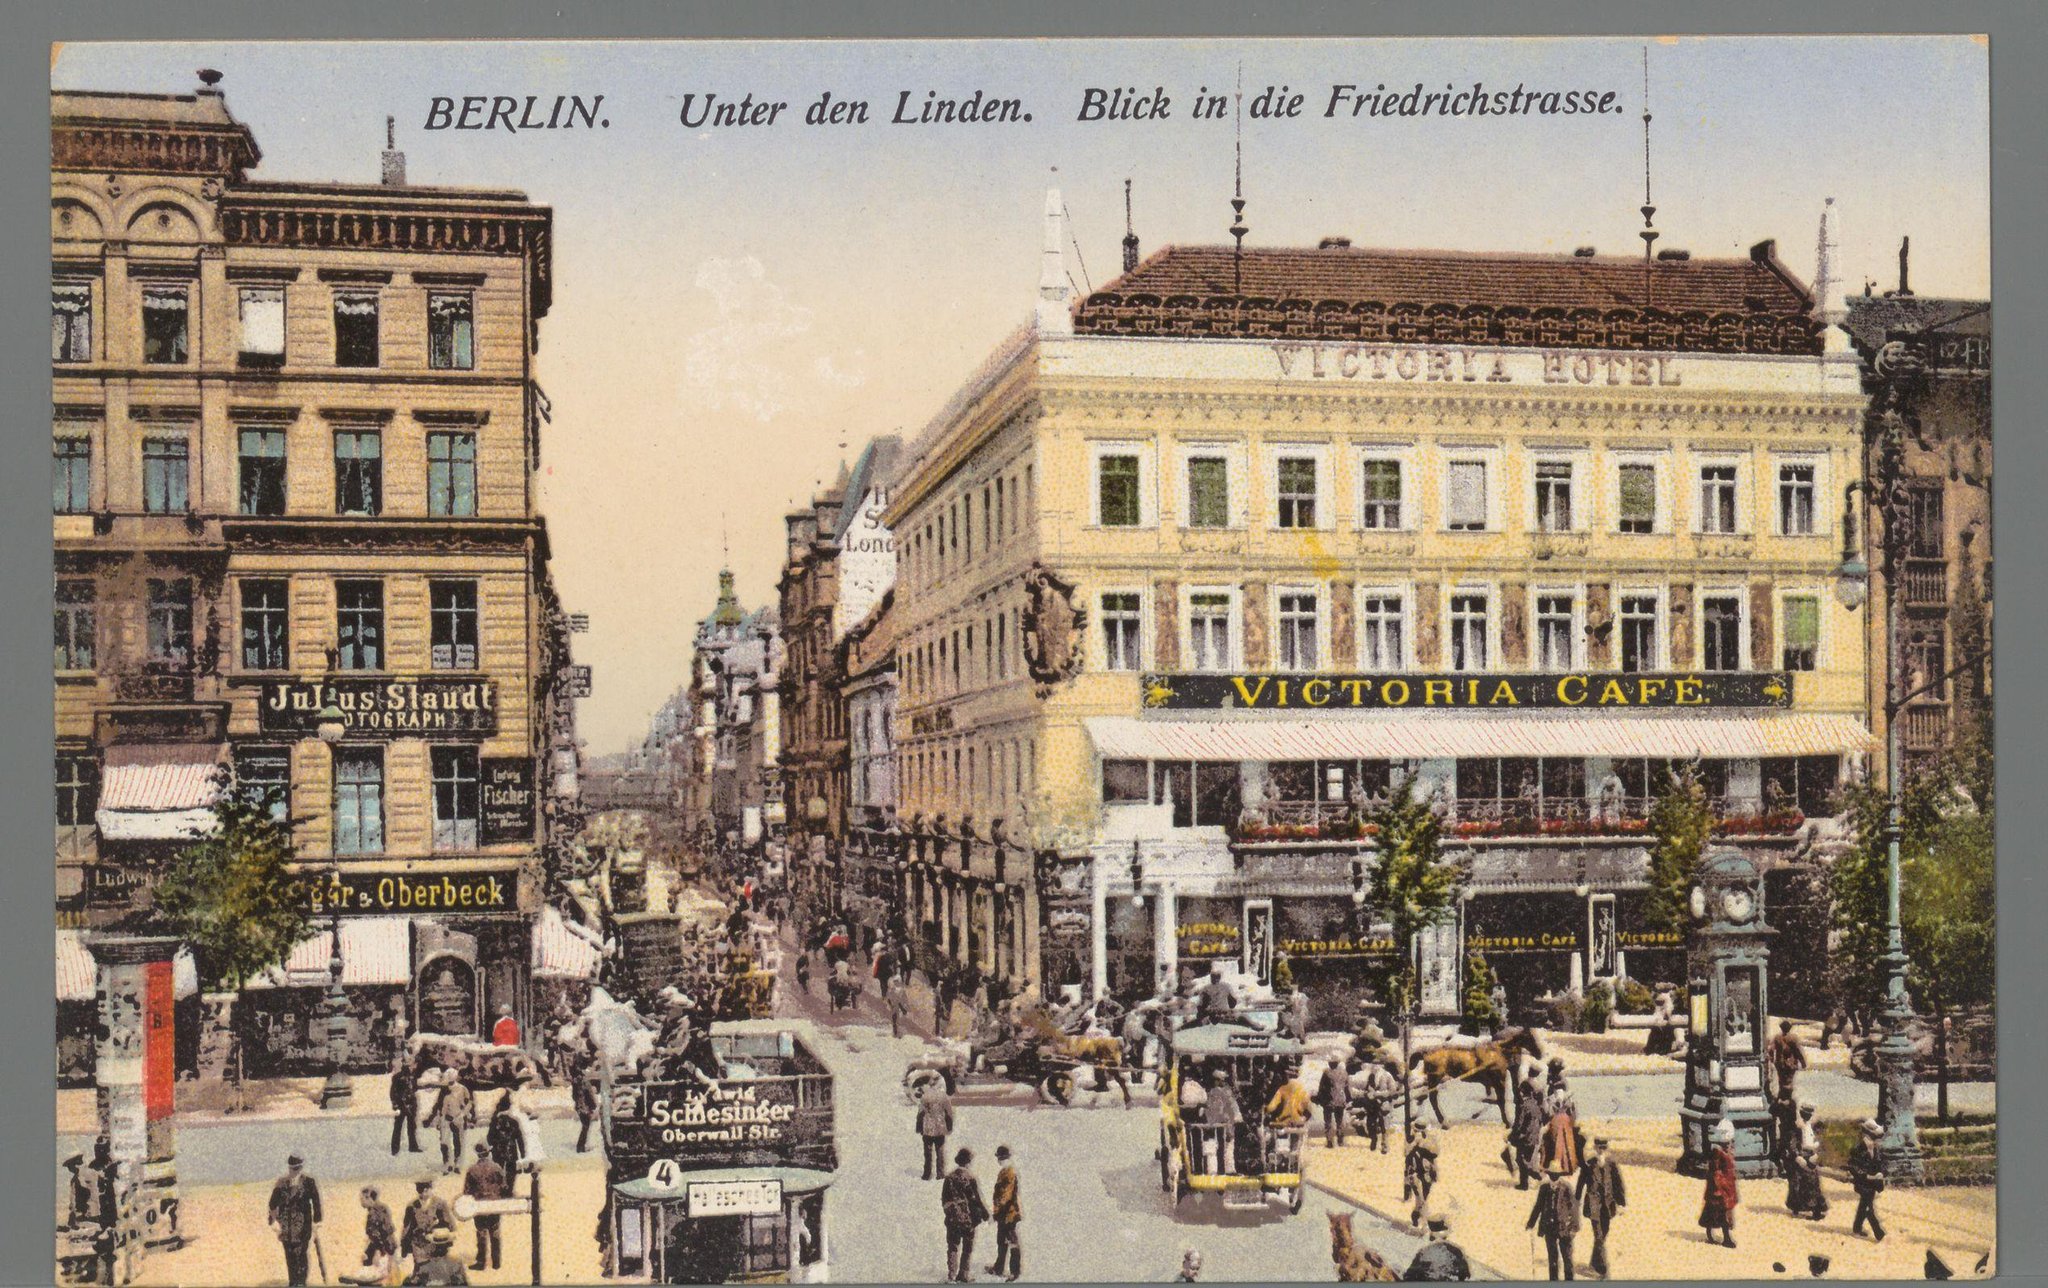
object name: photomechanical print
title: Berlin. Unter den Linden. Blick in die Friedrichstrasse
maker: Anonymous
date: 1905-1930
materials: cardboard, photographic process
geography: berlin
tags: street, hotel, hostelry, inn